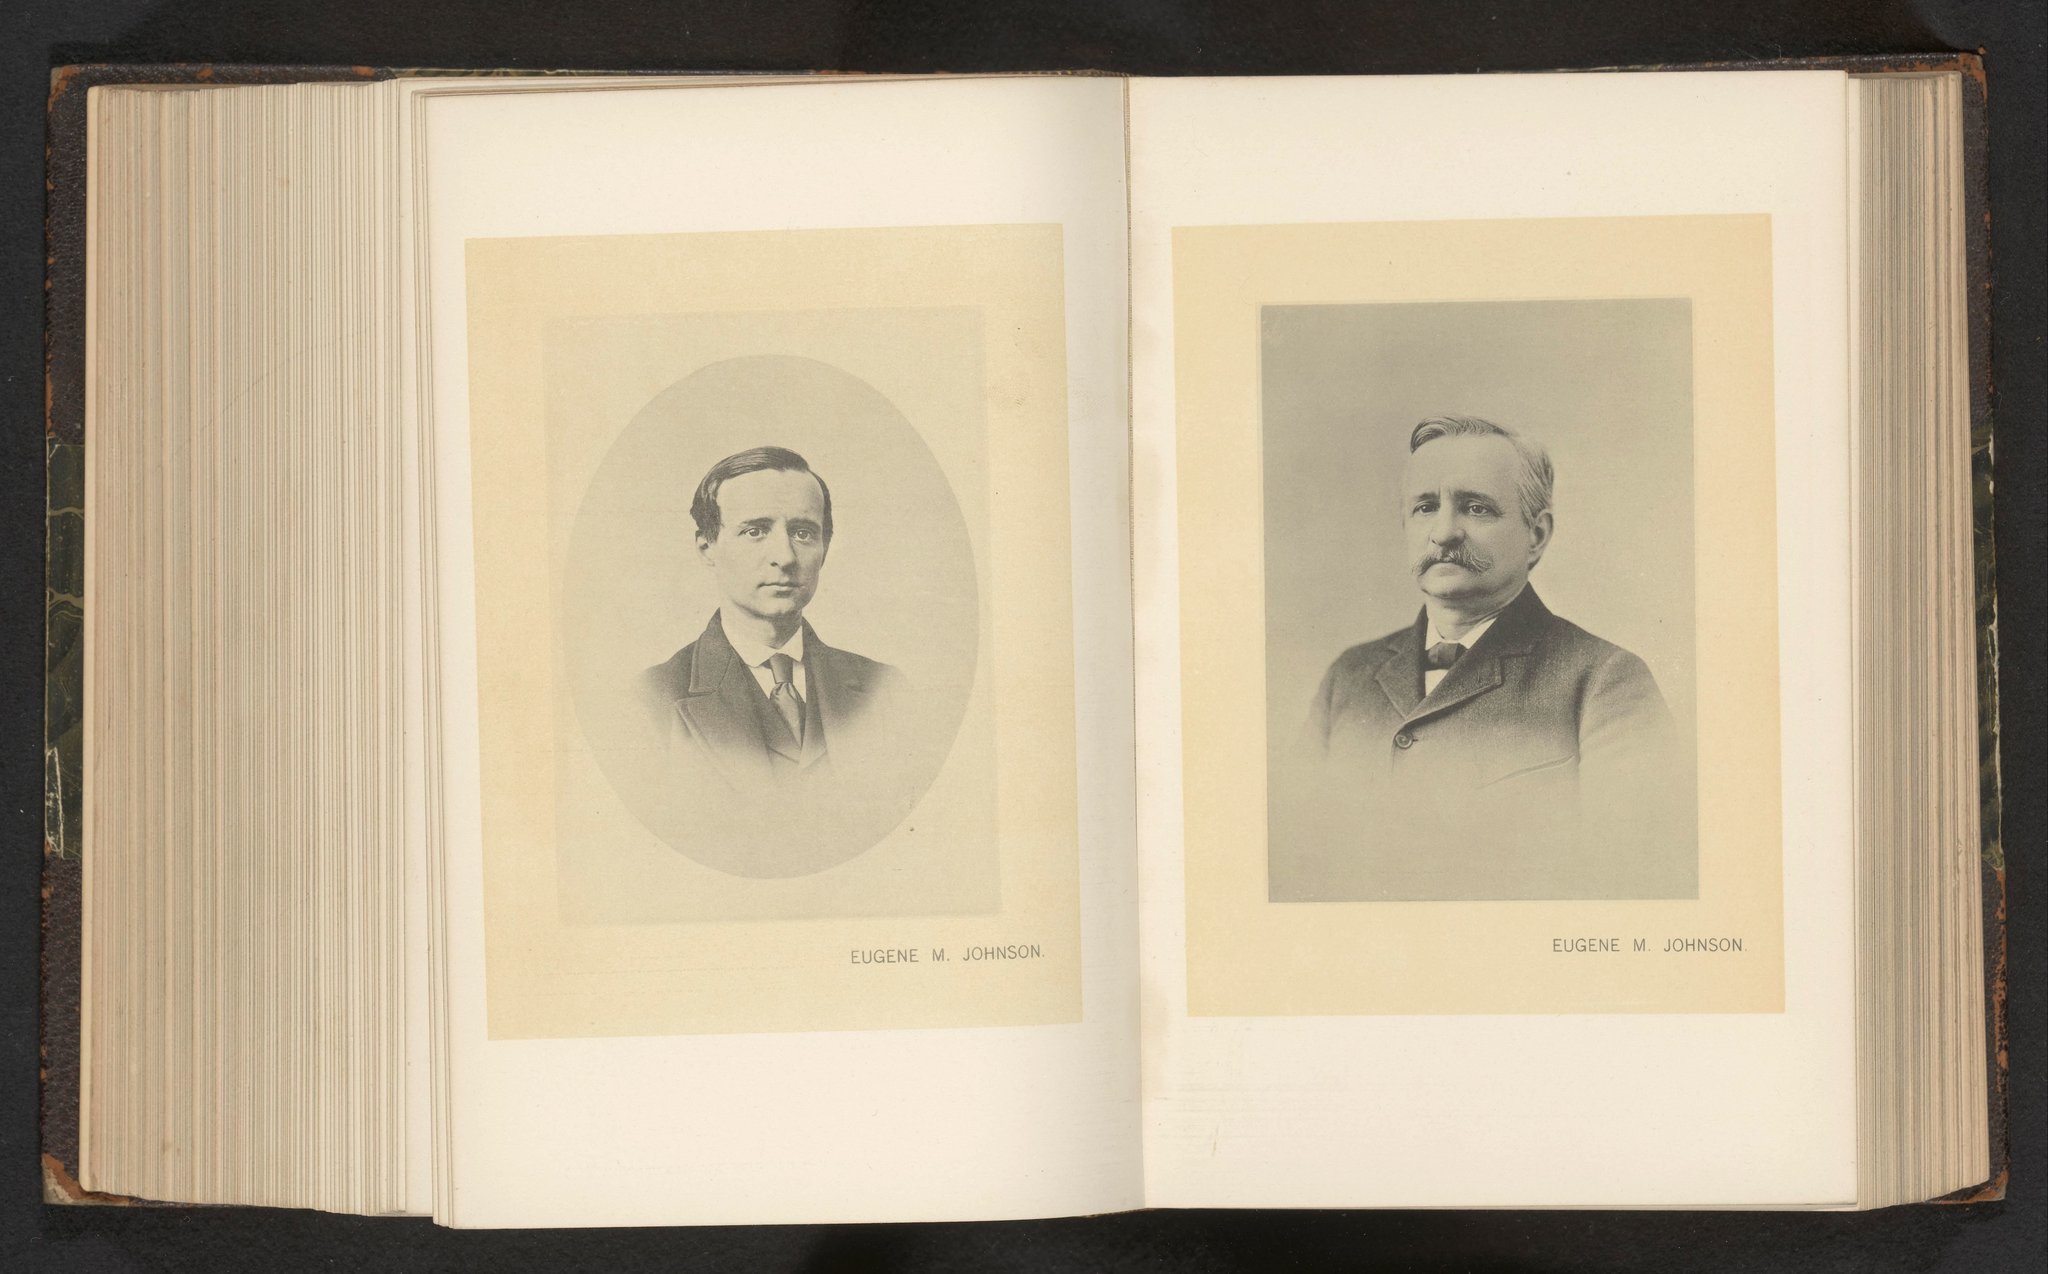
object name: page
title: Eugene M. Johnson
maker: Anonymous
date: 1889-1894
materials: paper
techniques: photoaquatint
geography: boston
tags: adult man